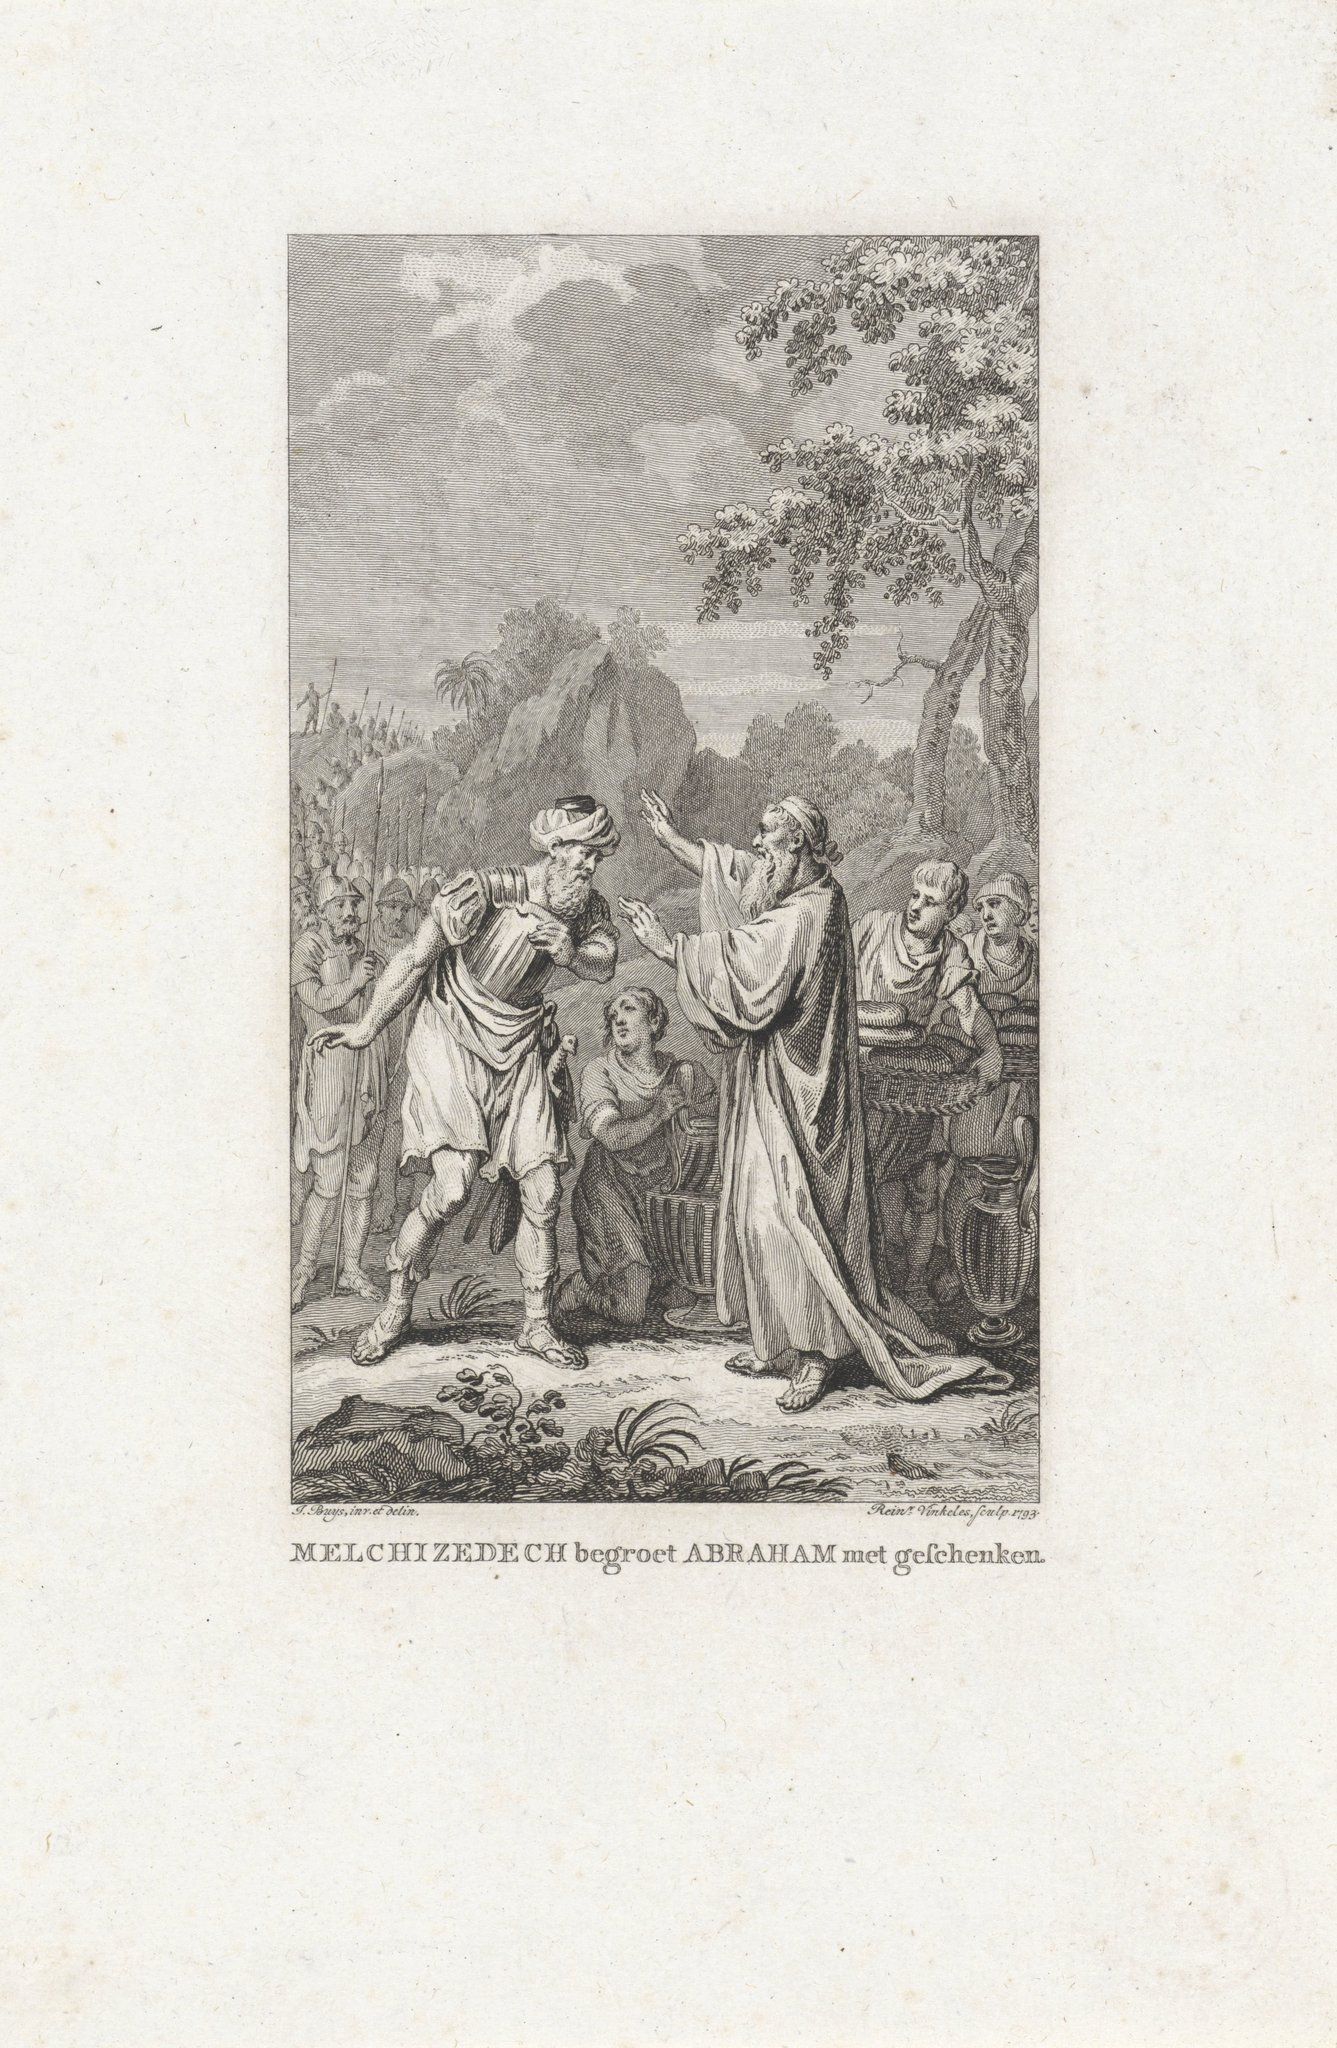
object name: print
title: Melchizedech begroet Abraham met geschenken.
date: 1793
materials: paper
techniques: engraving, etching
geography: amsterdam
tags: the meeting of abraham and melchizedek, the high priest and king of salem, who brings bread and wine (genesis 14:18-20)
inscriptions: collector's mark: Lugt 240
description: Abraham ontmoet de koning en hogepriester Melchisedek in Salem. Hij brengt brood en wijn en zegent Abraham.